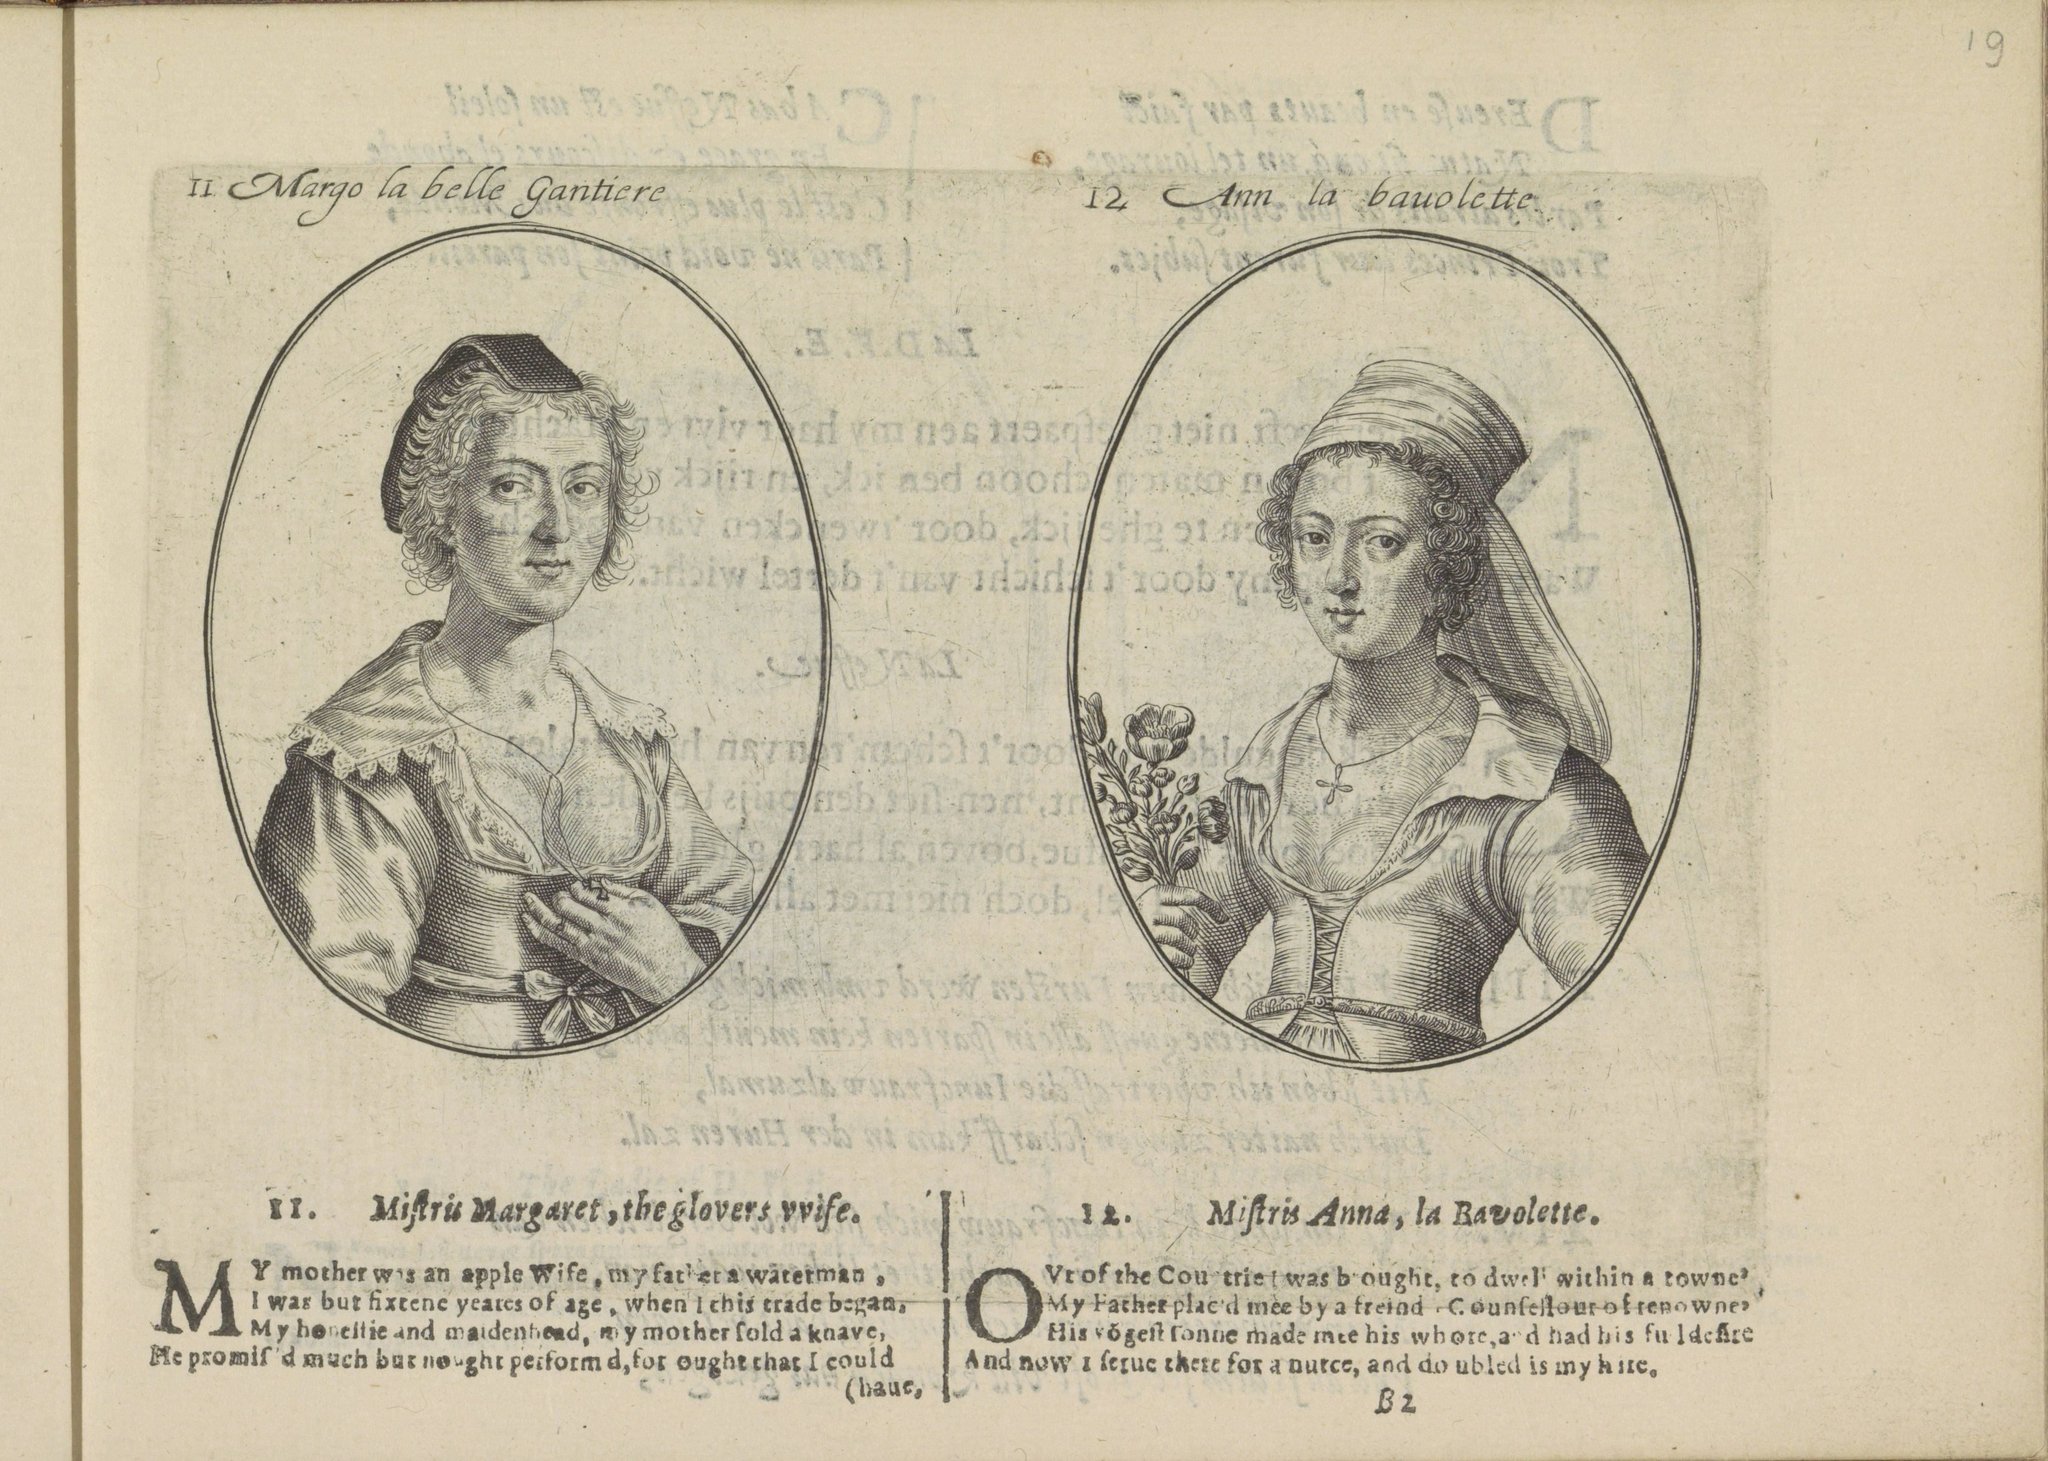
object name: print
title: Miroir des plus belles courtisanes de ce temps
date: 1635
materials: paper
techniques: engraving, letterpress printing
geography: utrecht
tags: herding, herdsman, herdswoman, shepherd, shepherdess, cowherd, etc.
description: Twee voorstellingen op een albumblad. Links de courtisane Margo de la belle Gantiere, de vrouw van een handschoenenmaker, en rechts Anna la Bavolette met bloemen in haar hand. Daaronder twee kwatrijnen in het Engels. Het blad maakt deel uit van een album.